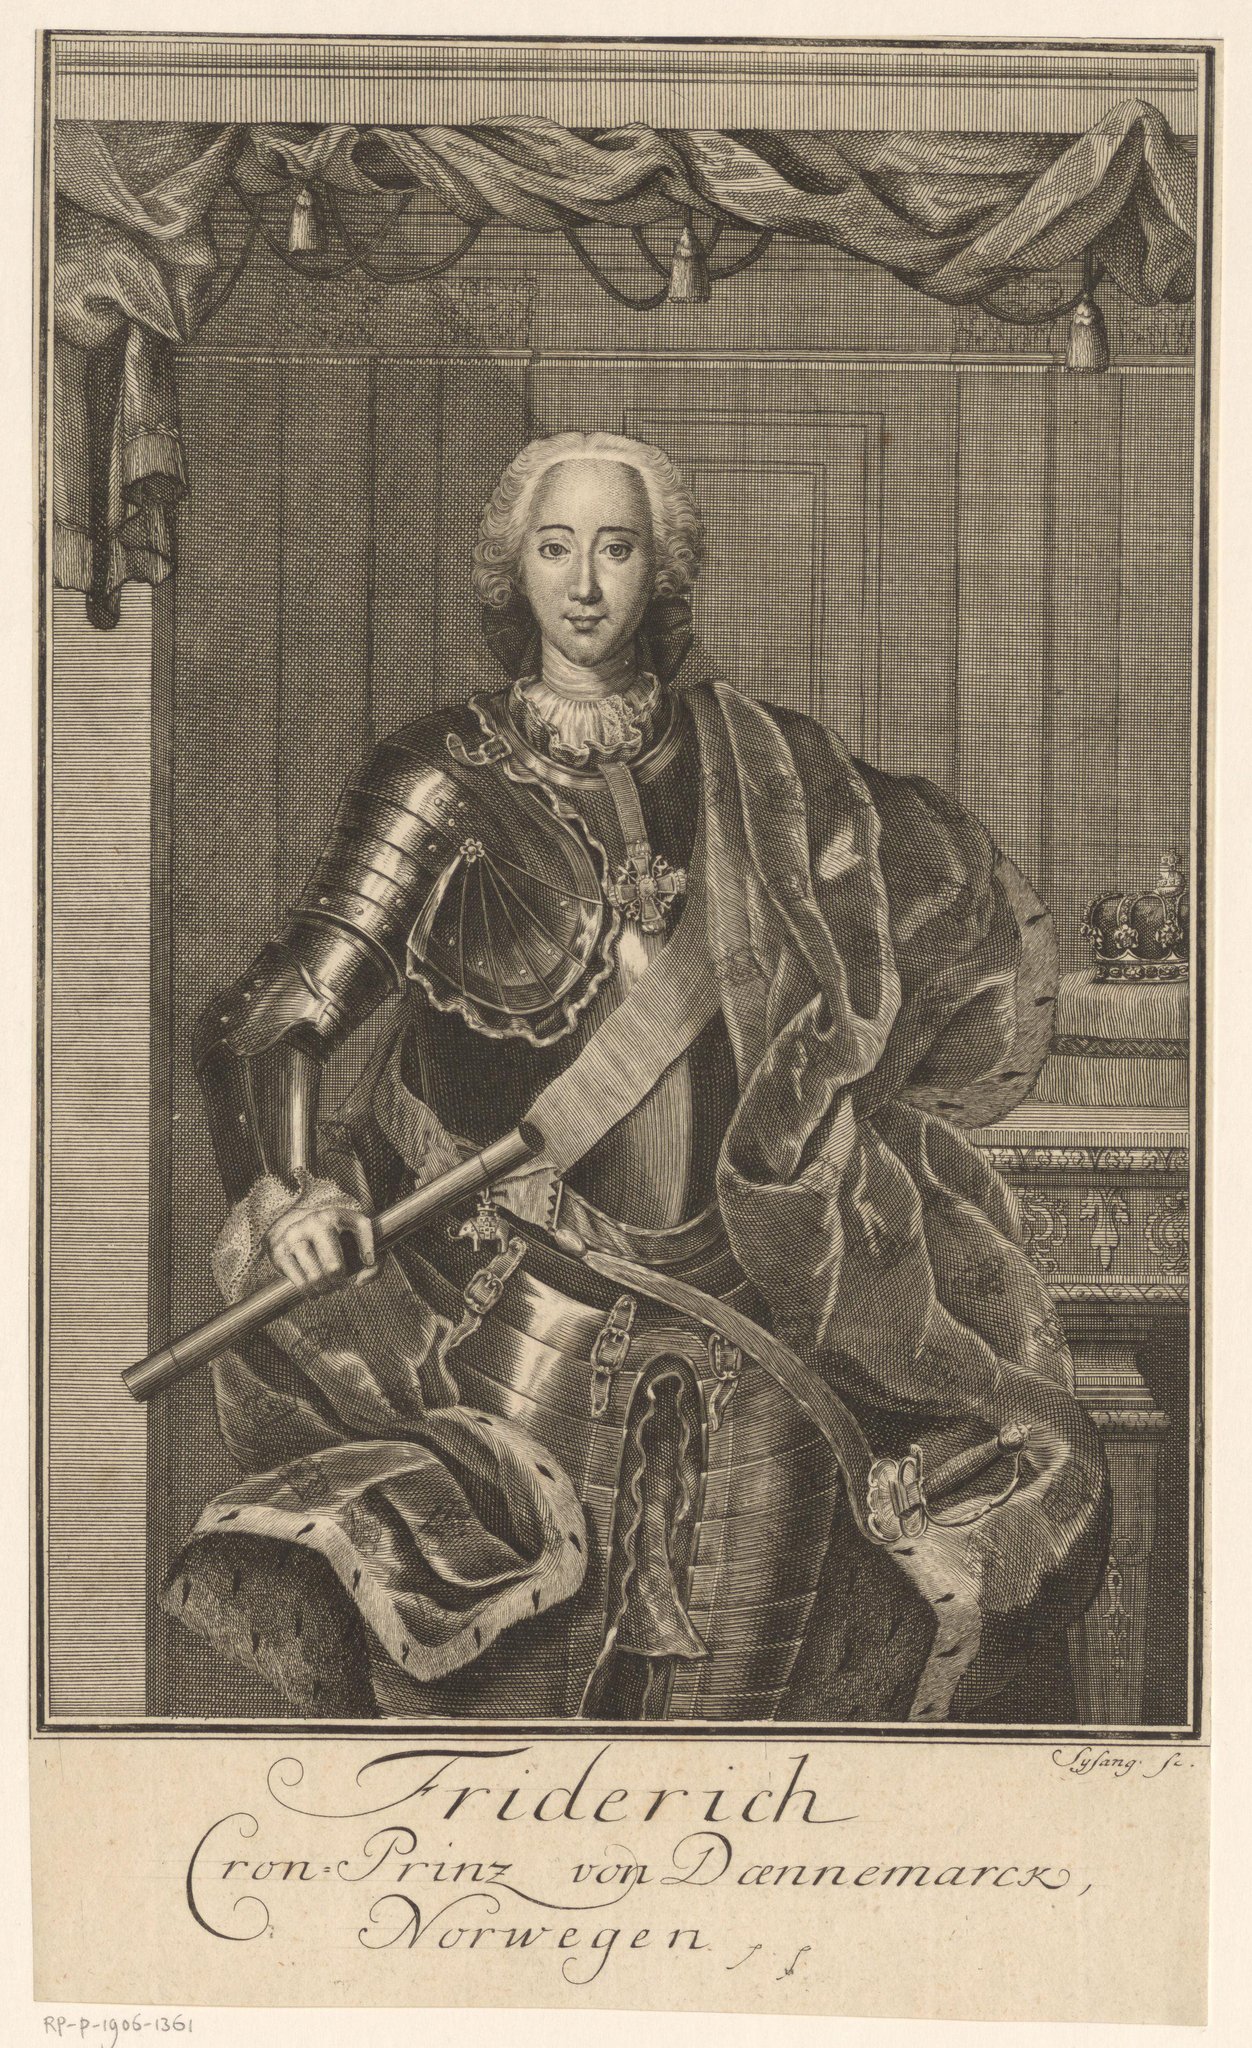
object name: print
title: Portret van Frederik V, koning van Denemarken en Noorwegen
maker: johann christoph sysang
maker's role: print maker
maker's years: 1703-1757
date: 1740-1746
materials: paper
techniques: engraving, etching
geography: leipzig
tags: copenhagen (city), armour, historical persons, baton of general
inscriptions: collector's mark: Lugt 2228